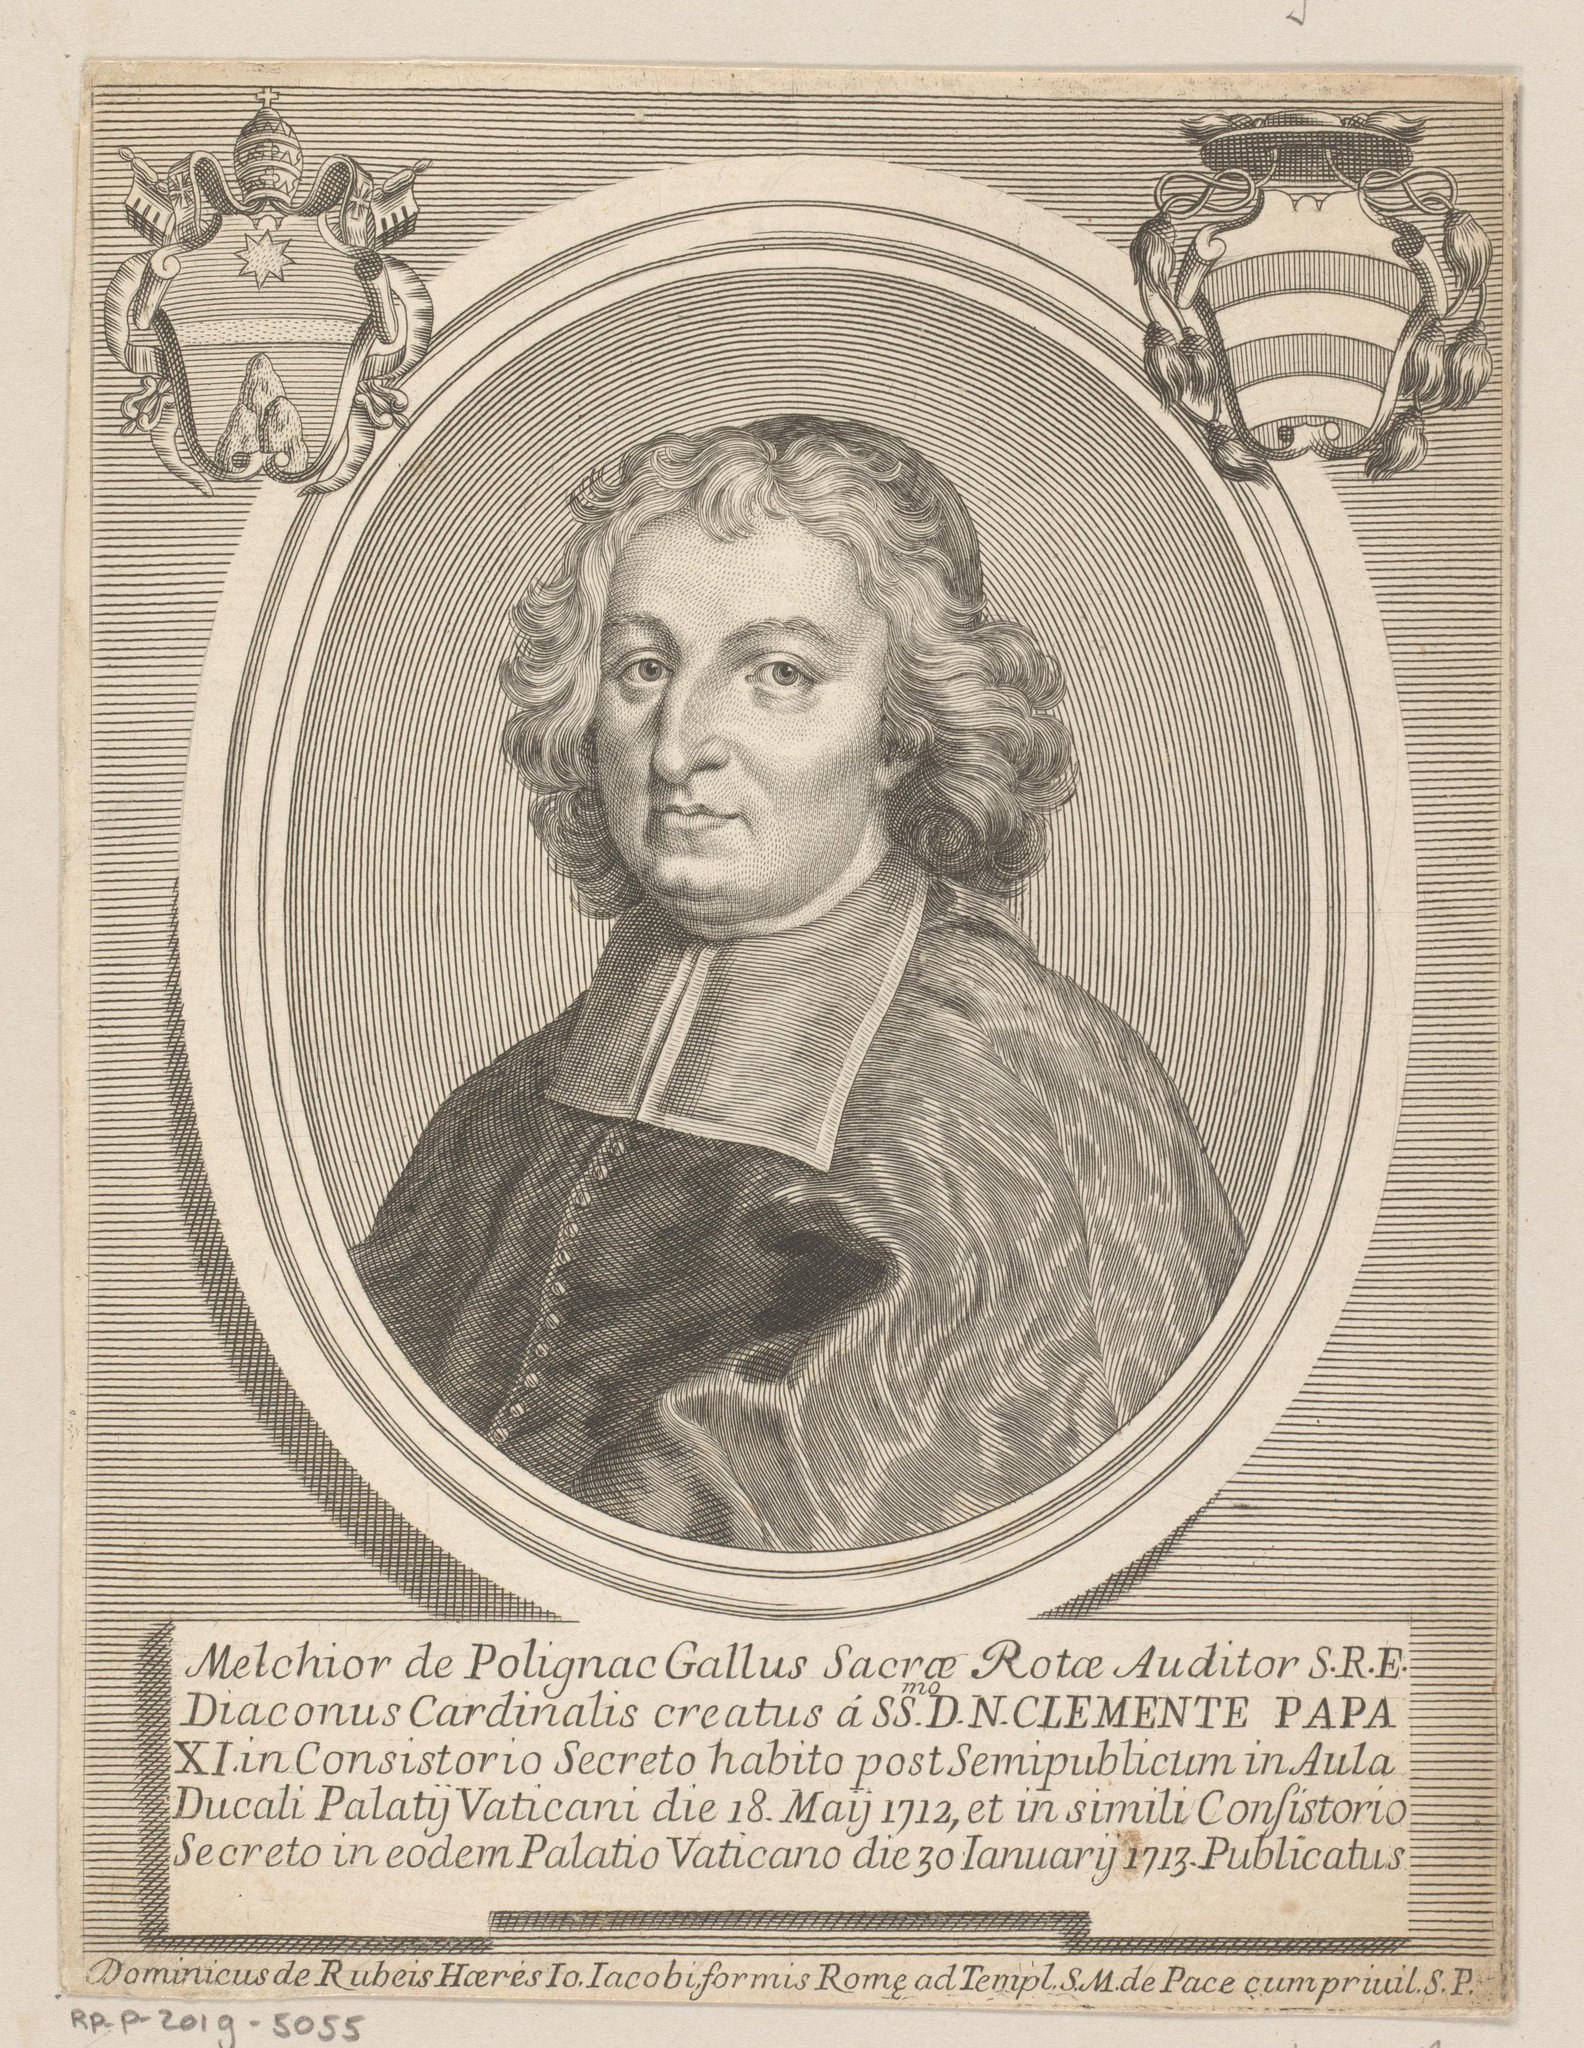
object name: print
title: Portretten van kardinalen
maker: Anonymous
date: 1713-1729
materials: paper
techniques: engraving, etching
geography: rome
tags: france, paris, melchior de polignac, cardinal, historical persons, armorial bearing, heraldry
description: Met rechtsboven zijn wapenschild en linksboven het wapen van paus Clemens XI.